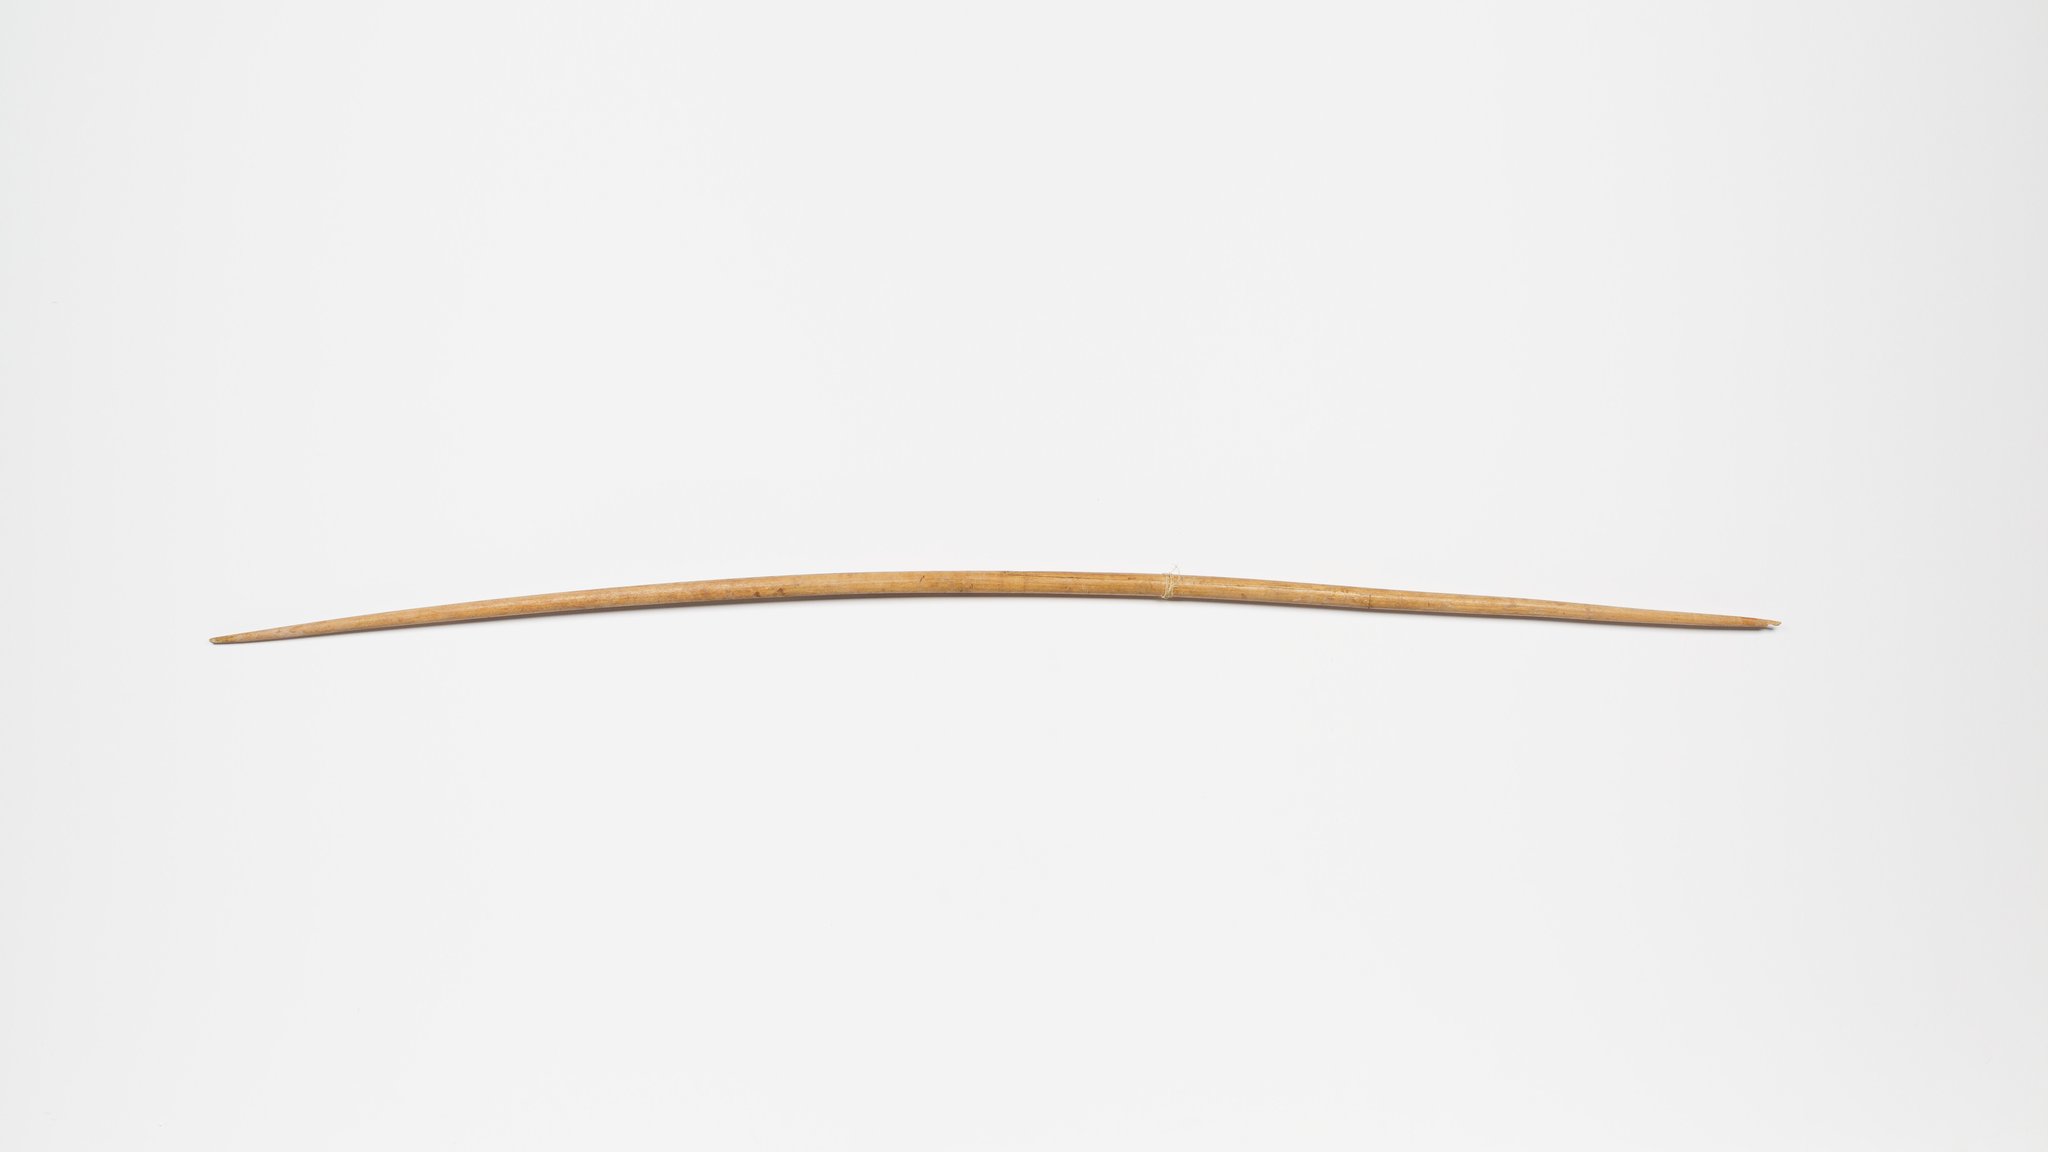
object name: bow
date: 2030-1650 BCE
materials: wood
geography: egypt